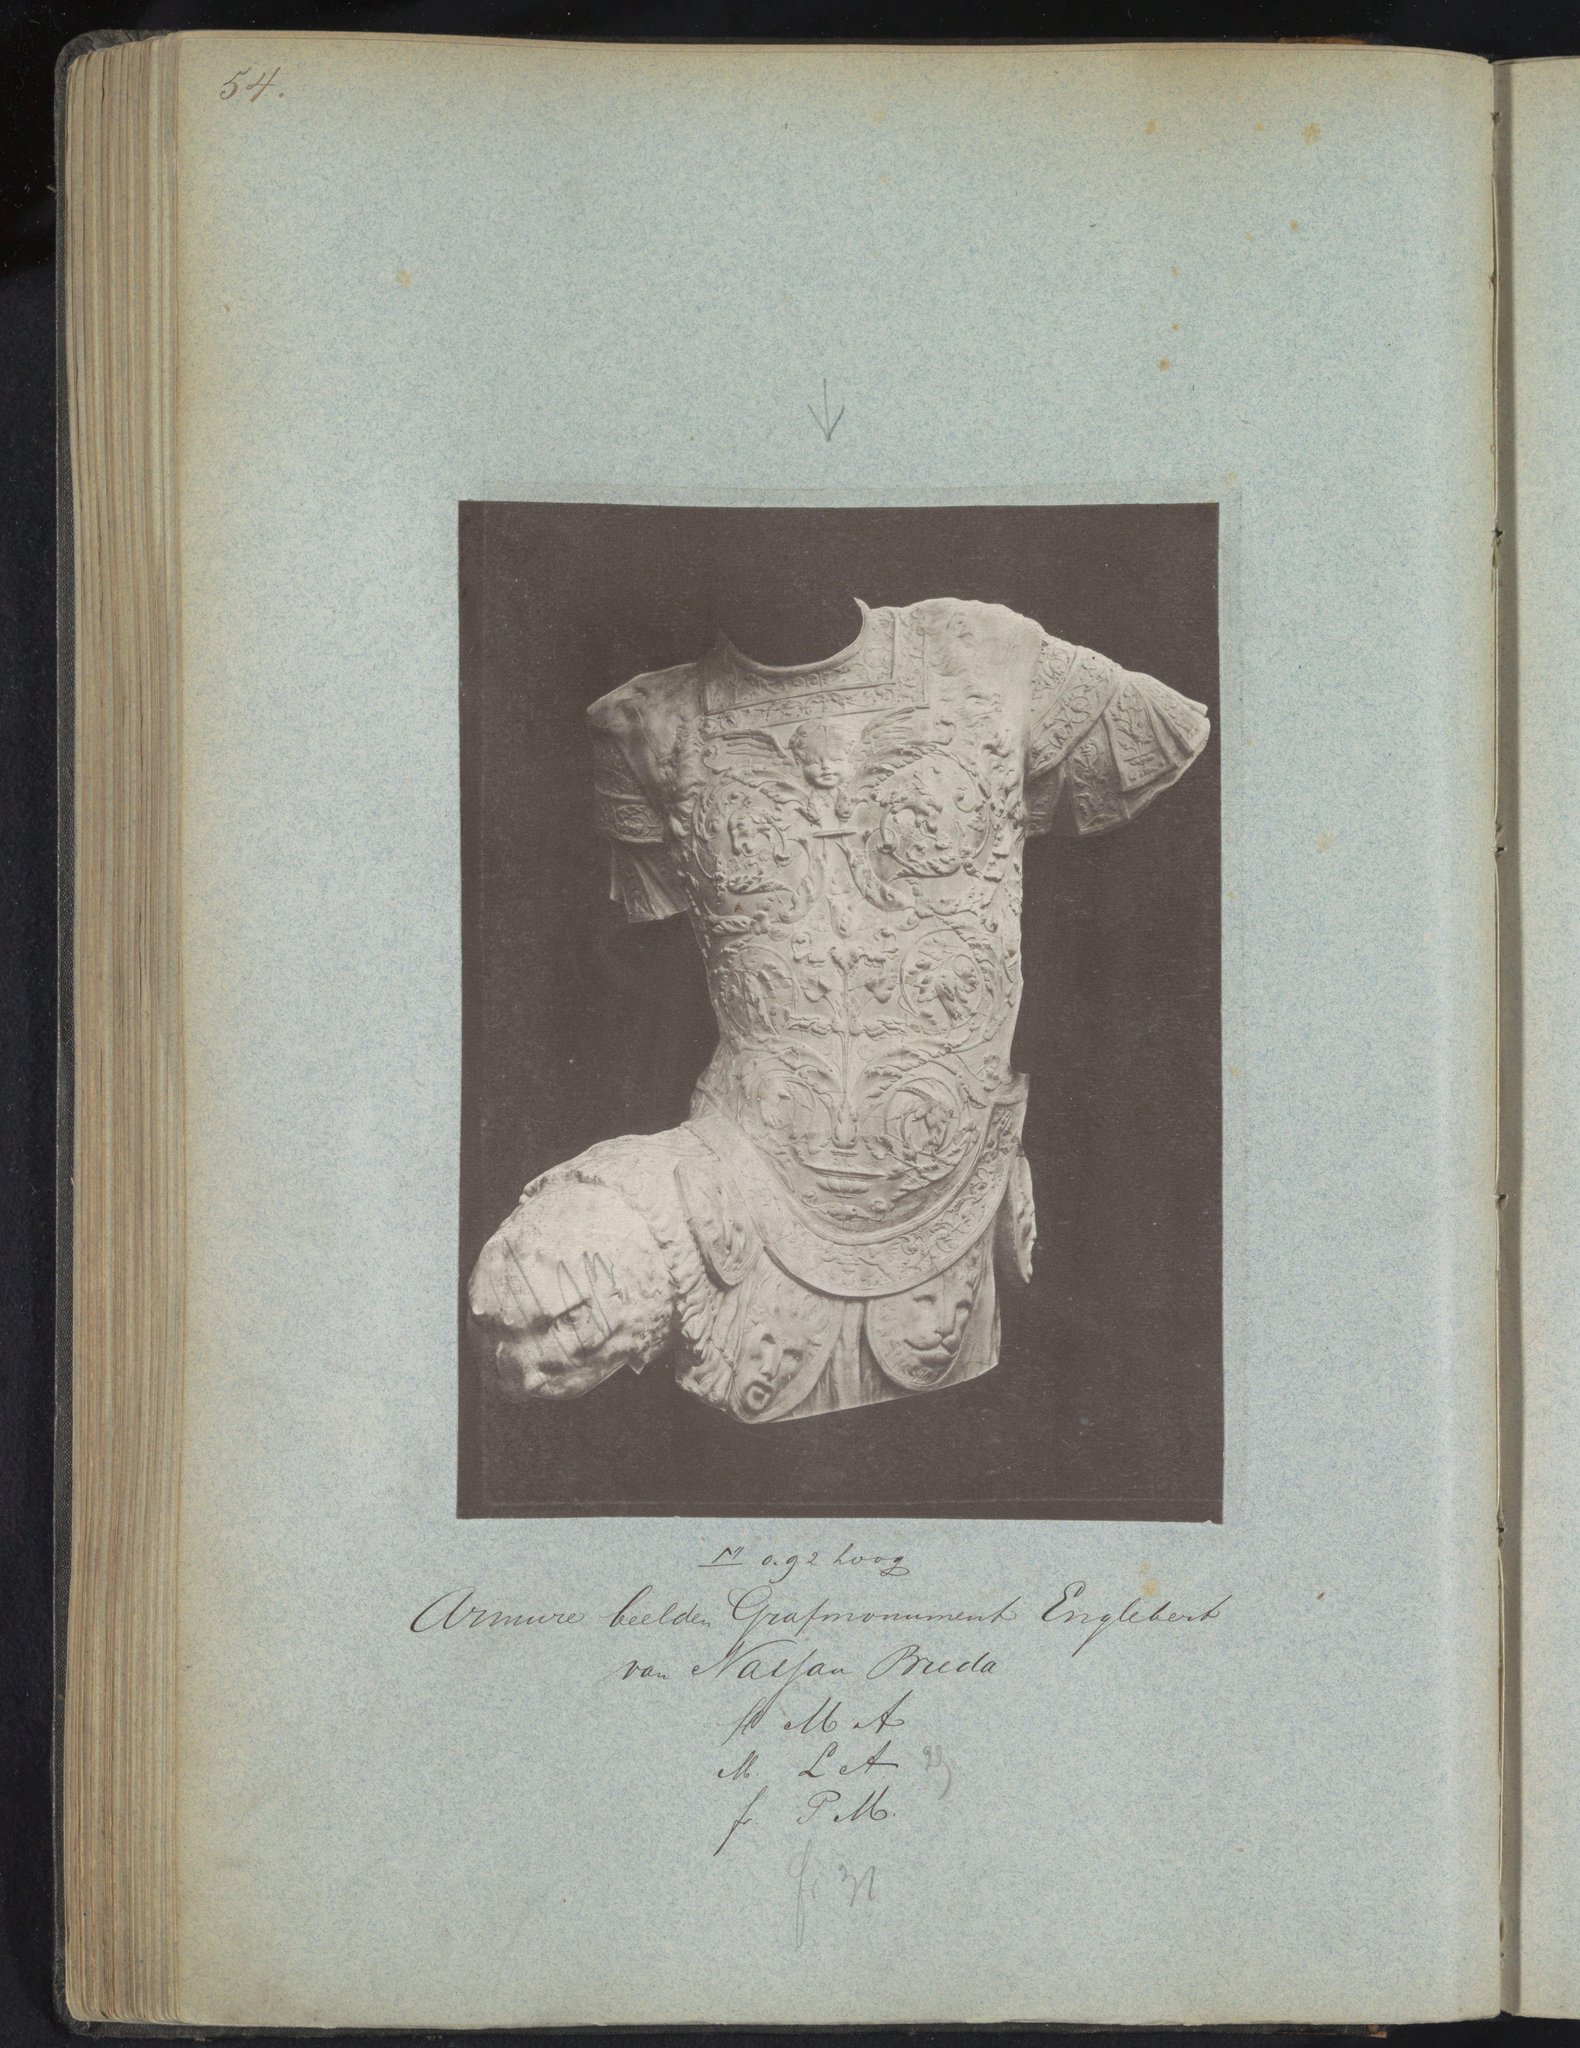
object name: photograph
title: Gipsen afgietsel van een harnas van het grafmonument van Engelbrecht II, graaf van van Nassau, uit de Prinsenkapel van de Onze-Lieve-Vrouwekerk te Breda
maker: Anonymous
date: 1875-1900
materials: paper, photographic support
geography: breda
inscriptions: annotation: ‘Armure beelden Grafmonument Englebert / van Nassau Breda’, annotation: ‘M 0.92 hoog’, annotation